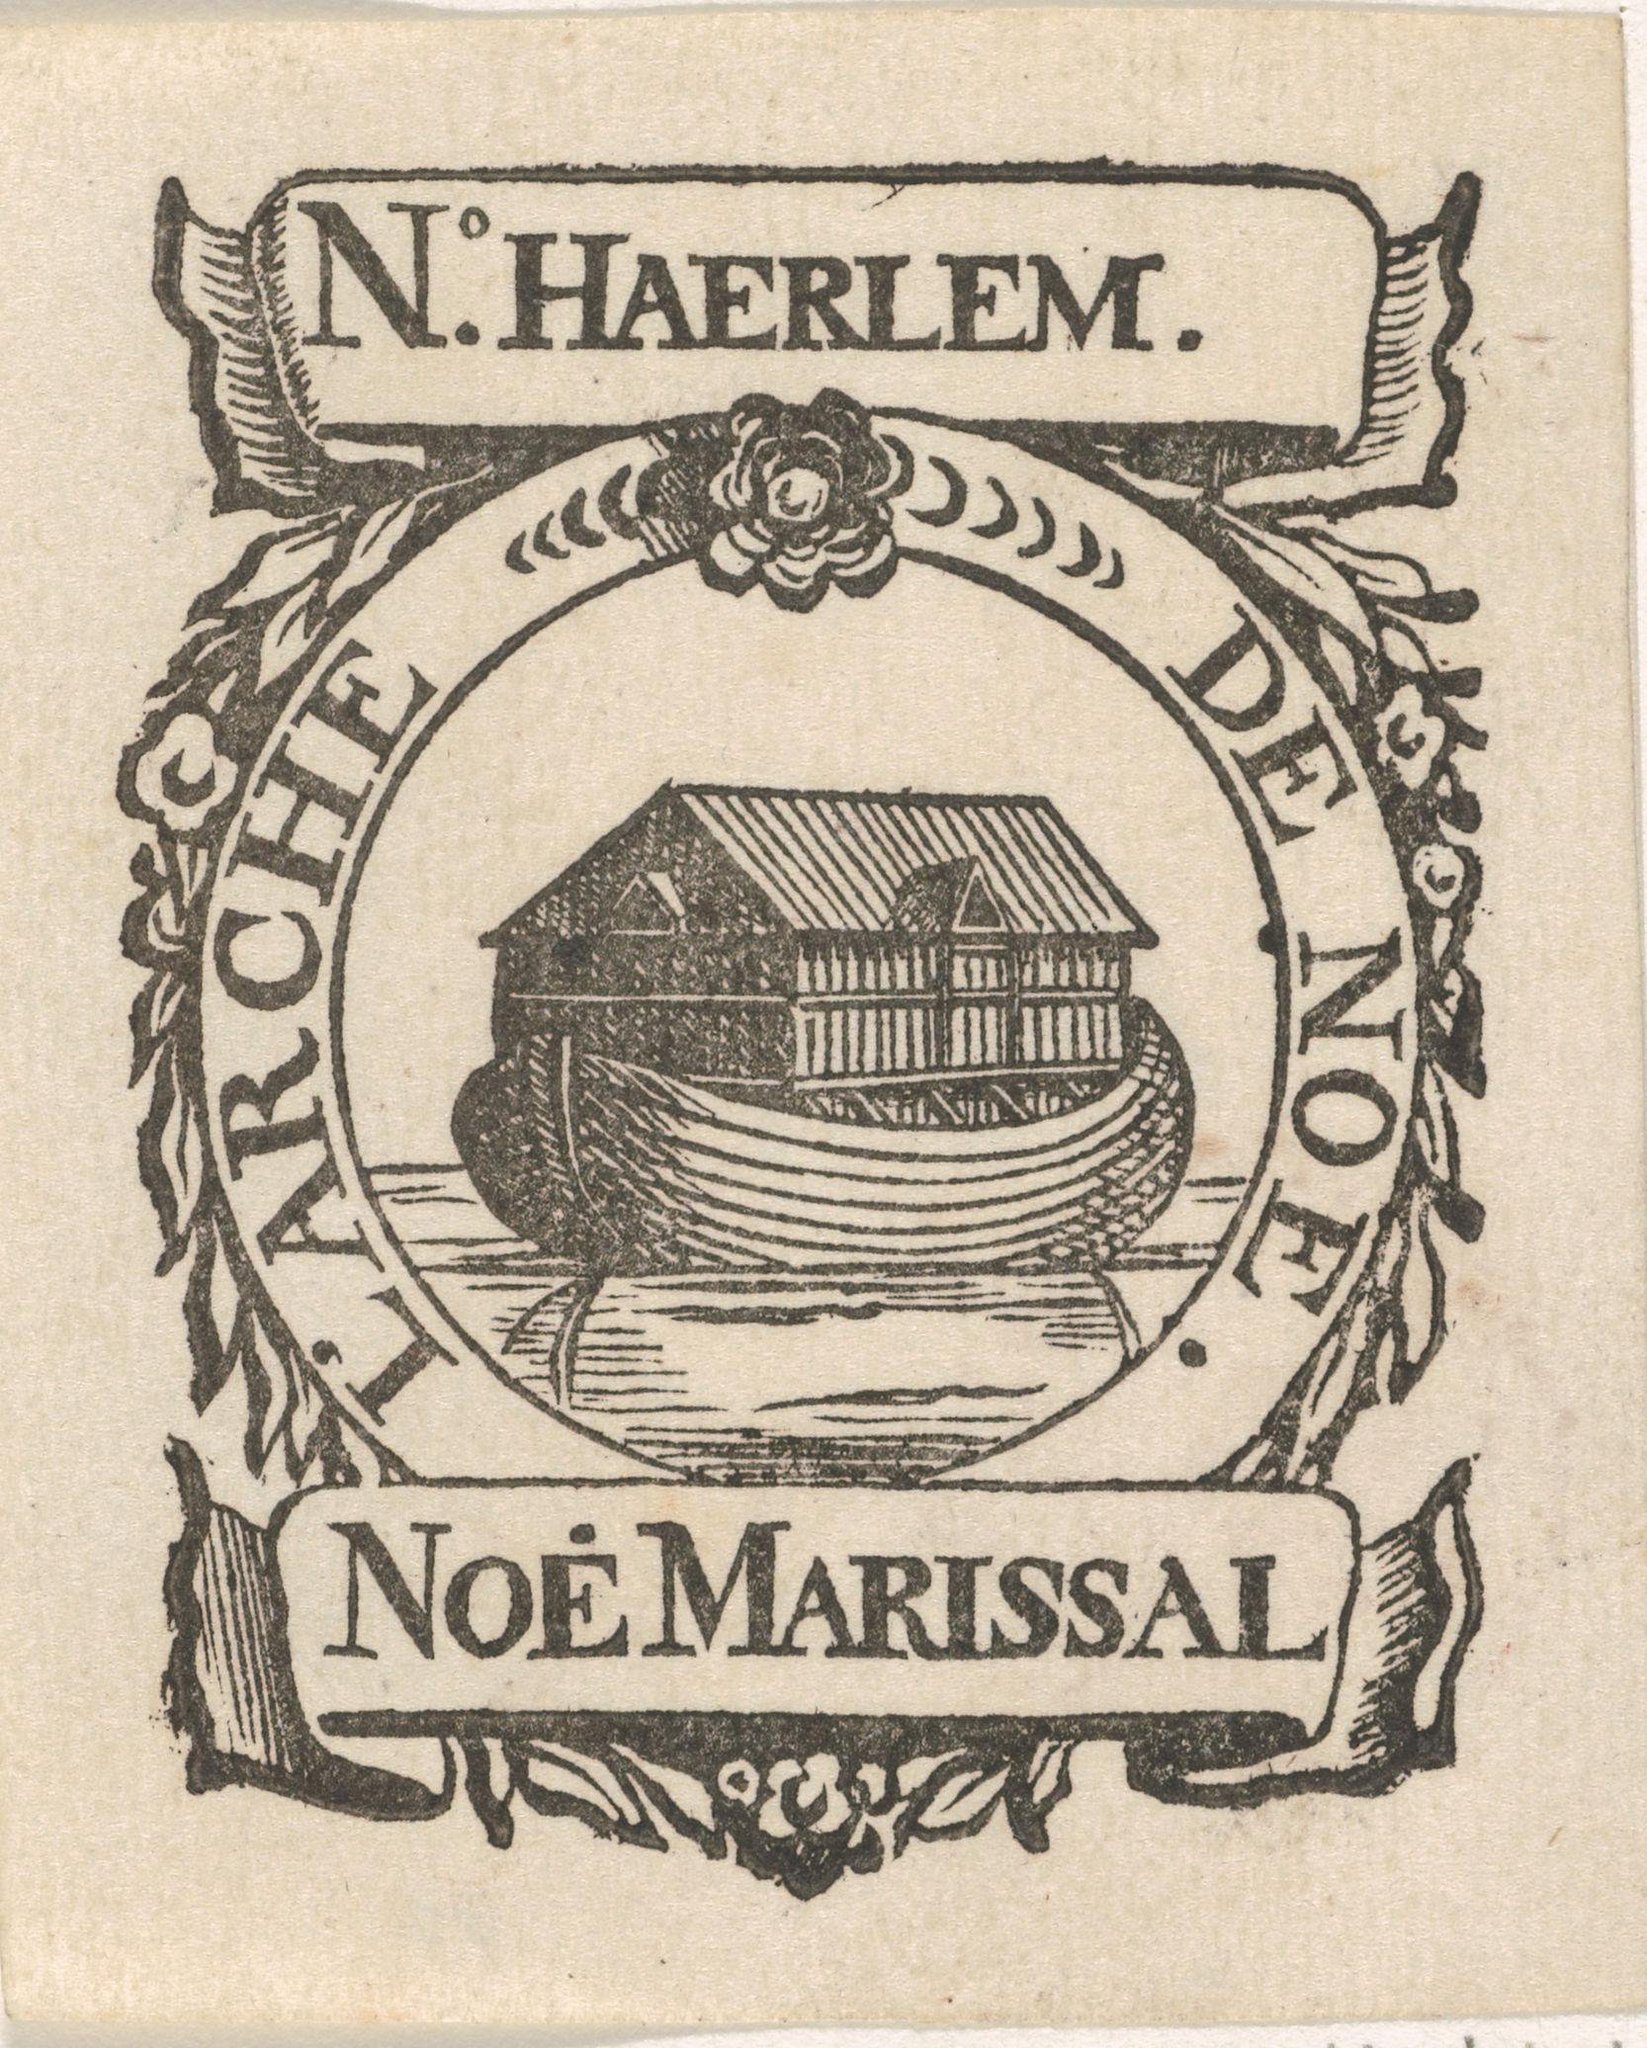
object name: print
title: L'arche de Noe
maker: isaac vincentsz. van der vinne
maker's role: draughtsman, print maker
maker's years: 1665-1740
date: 1681-1740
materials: paper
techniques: woodcut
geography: haarlem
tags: the building of the ark, and the embarkation (genesis 7:5-9), vignette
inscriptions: collector's mark: Lugt 240